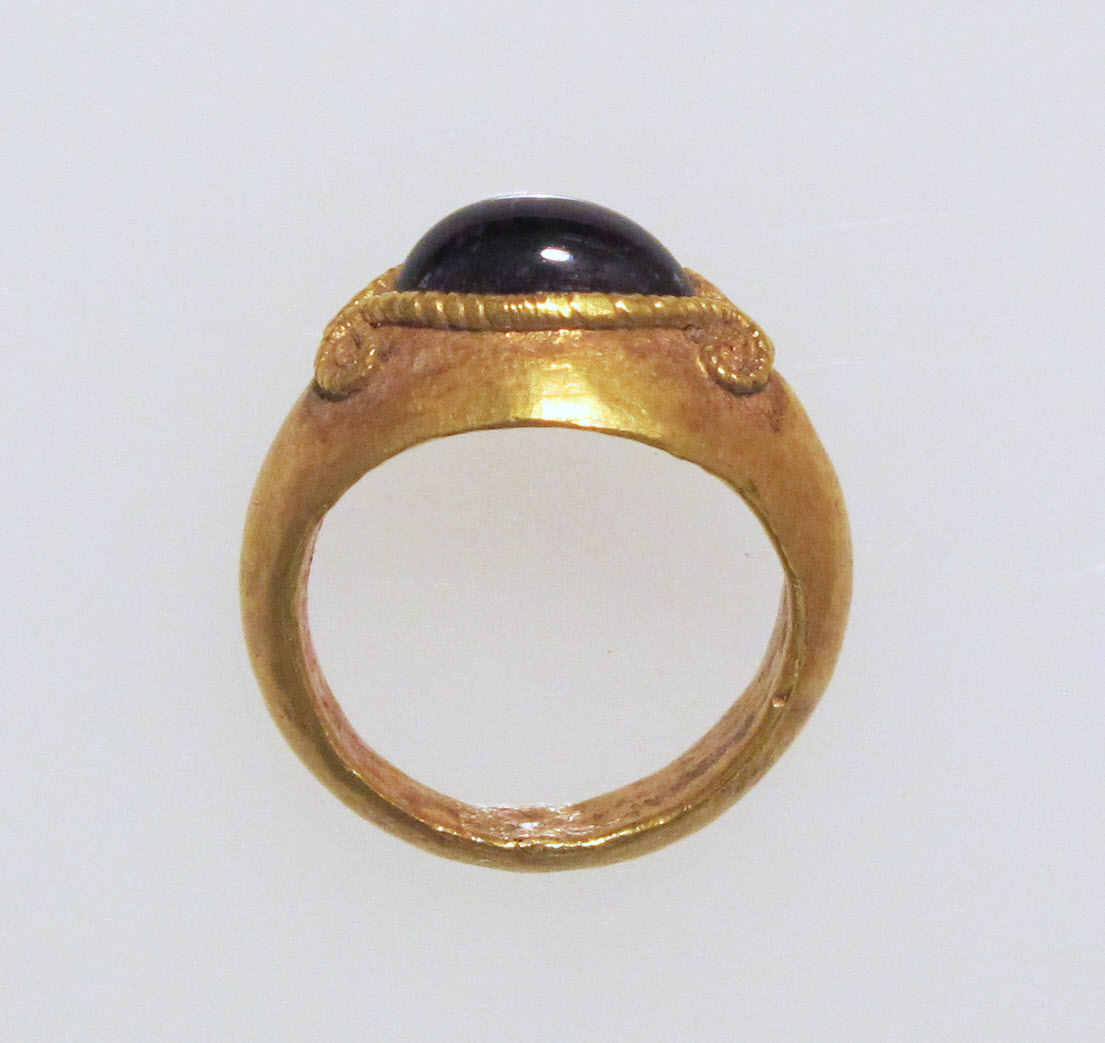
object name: ring with carbuncle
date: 7000 BCE-330 CE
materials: gold